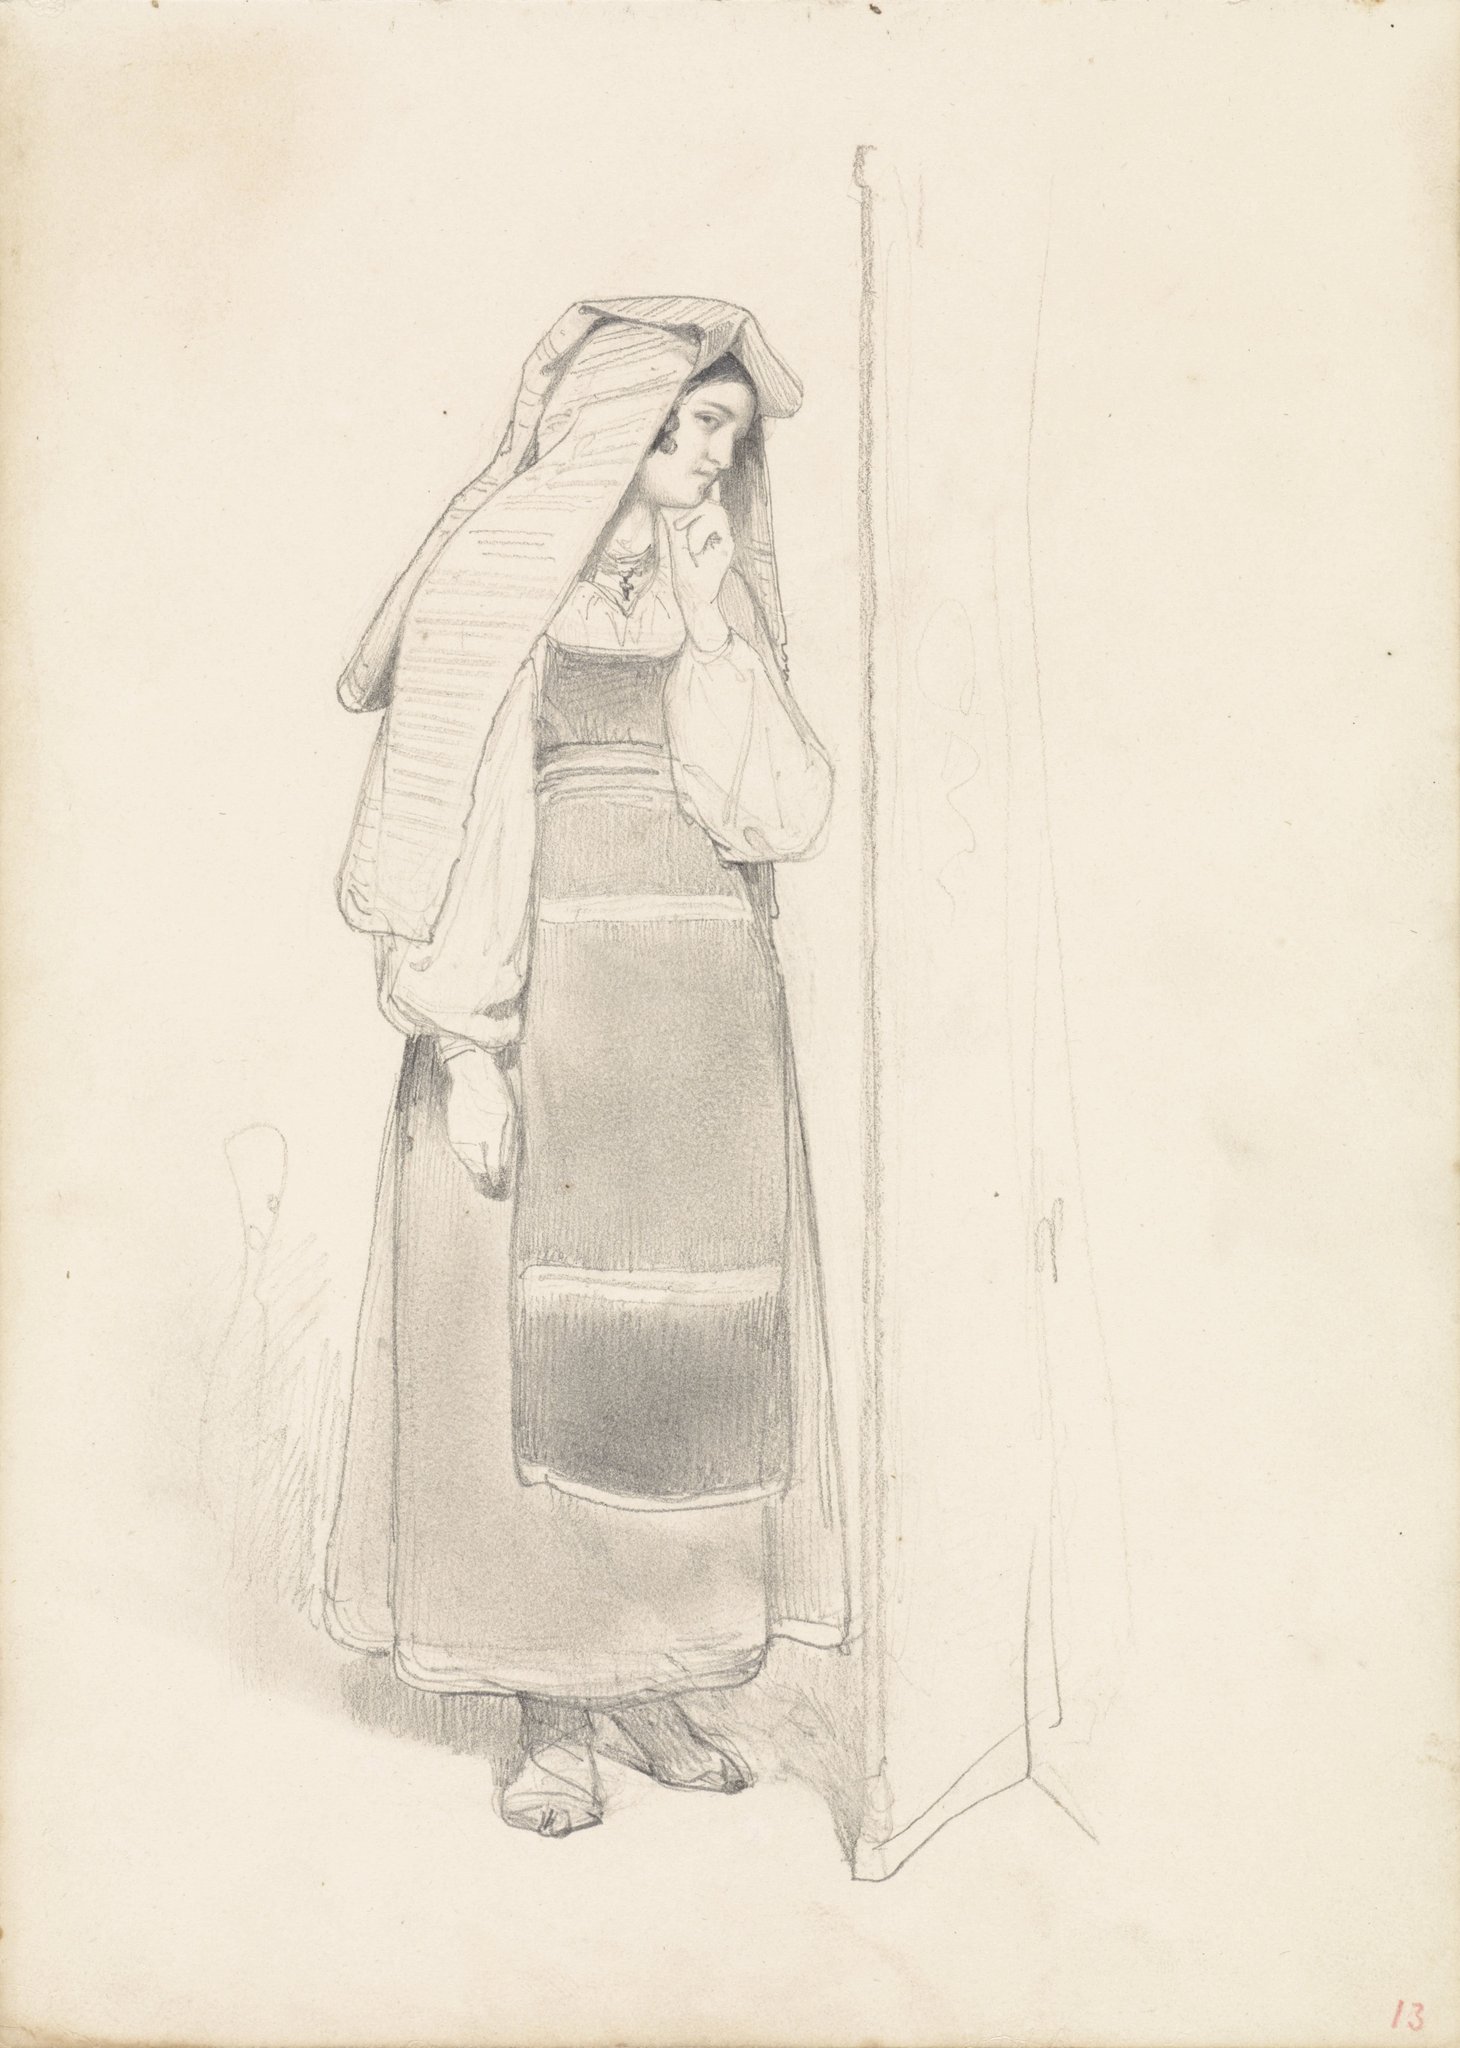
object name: drawing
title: Staand meisje met de hand aan het hoofd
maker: johan hendrik koelman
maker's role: draughtsman, print maker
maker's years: 1820-1887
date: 1830-1887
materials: paper, pencil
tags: folk costume, regional costume, italy